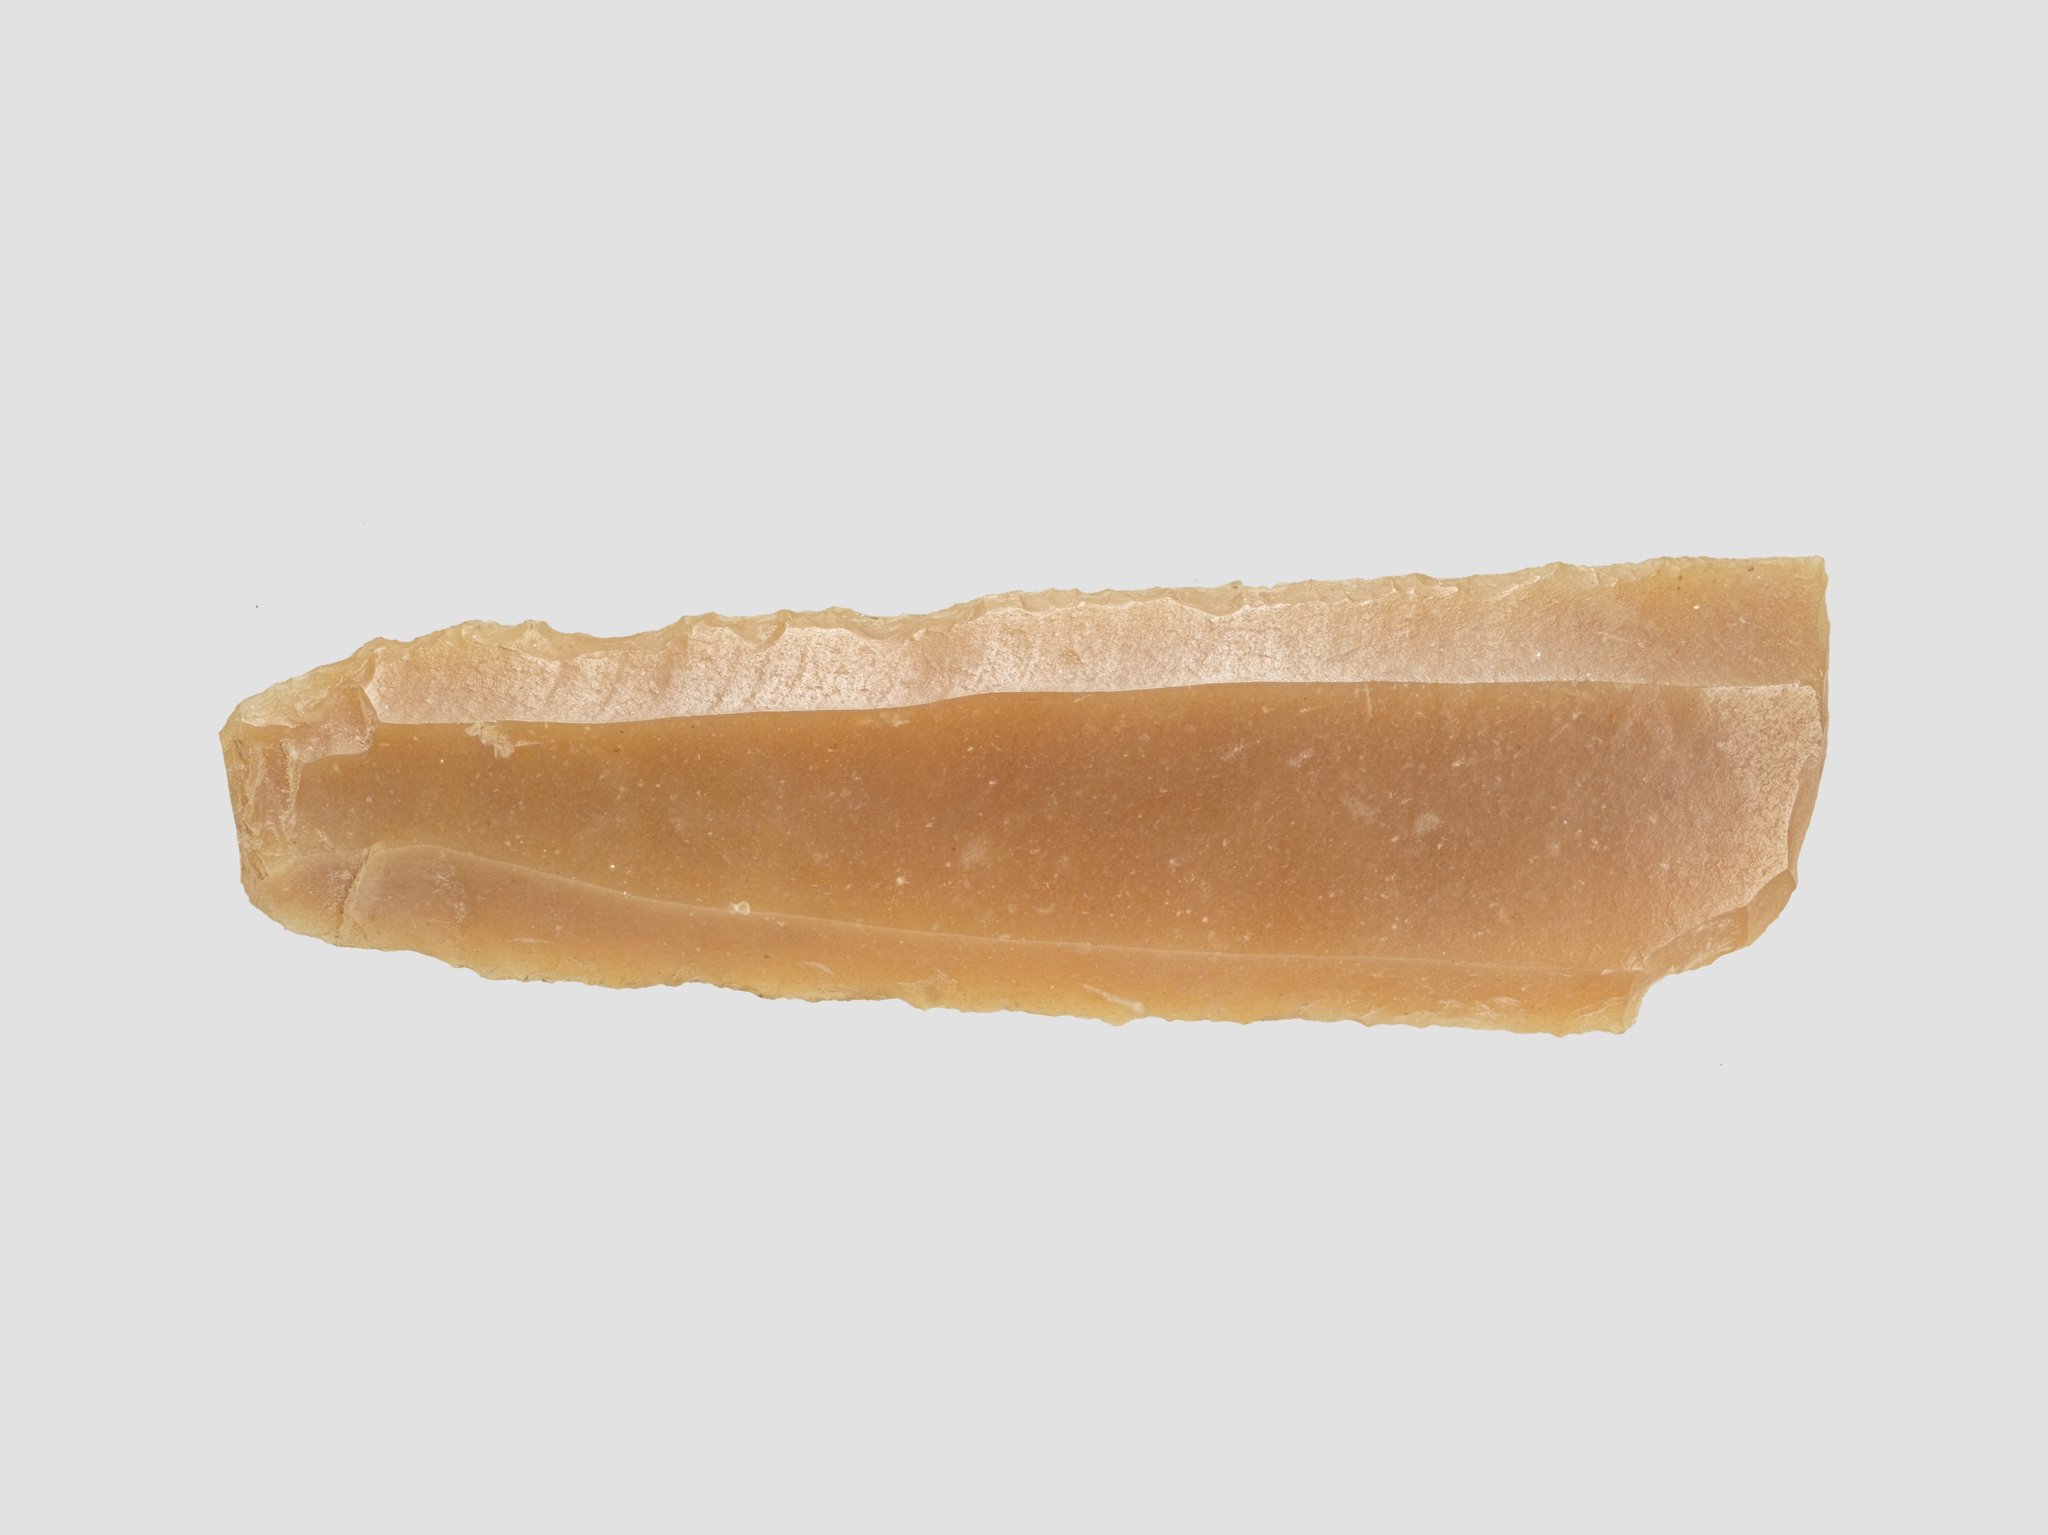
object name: tool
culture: iranian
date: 5000-2001 BCE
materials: obsidian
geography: iran